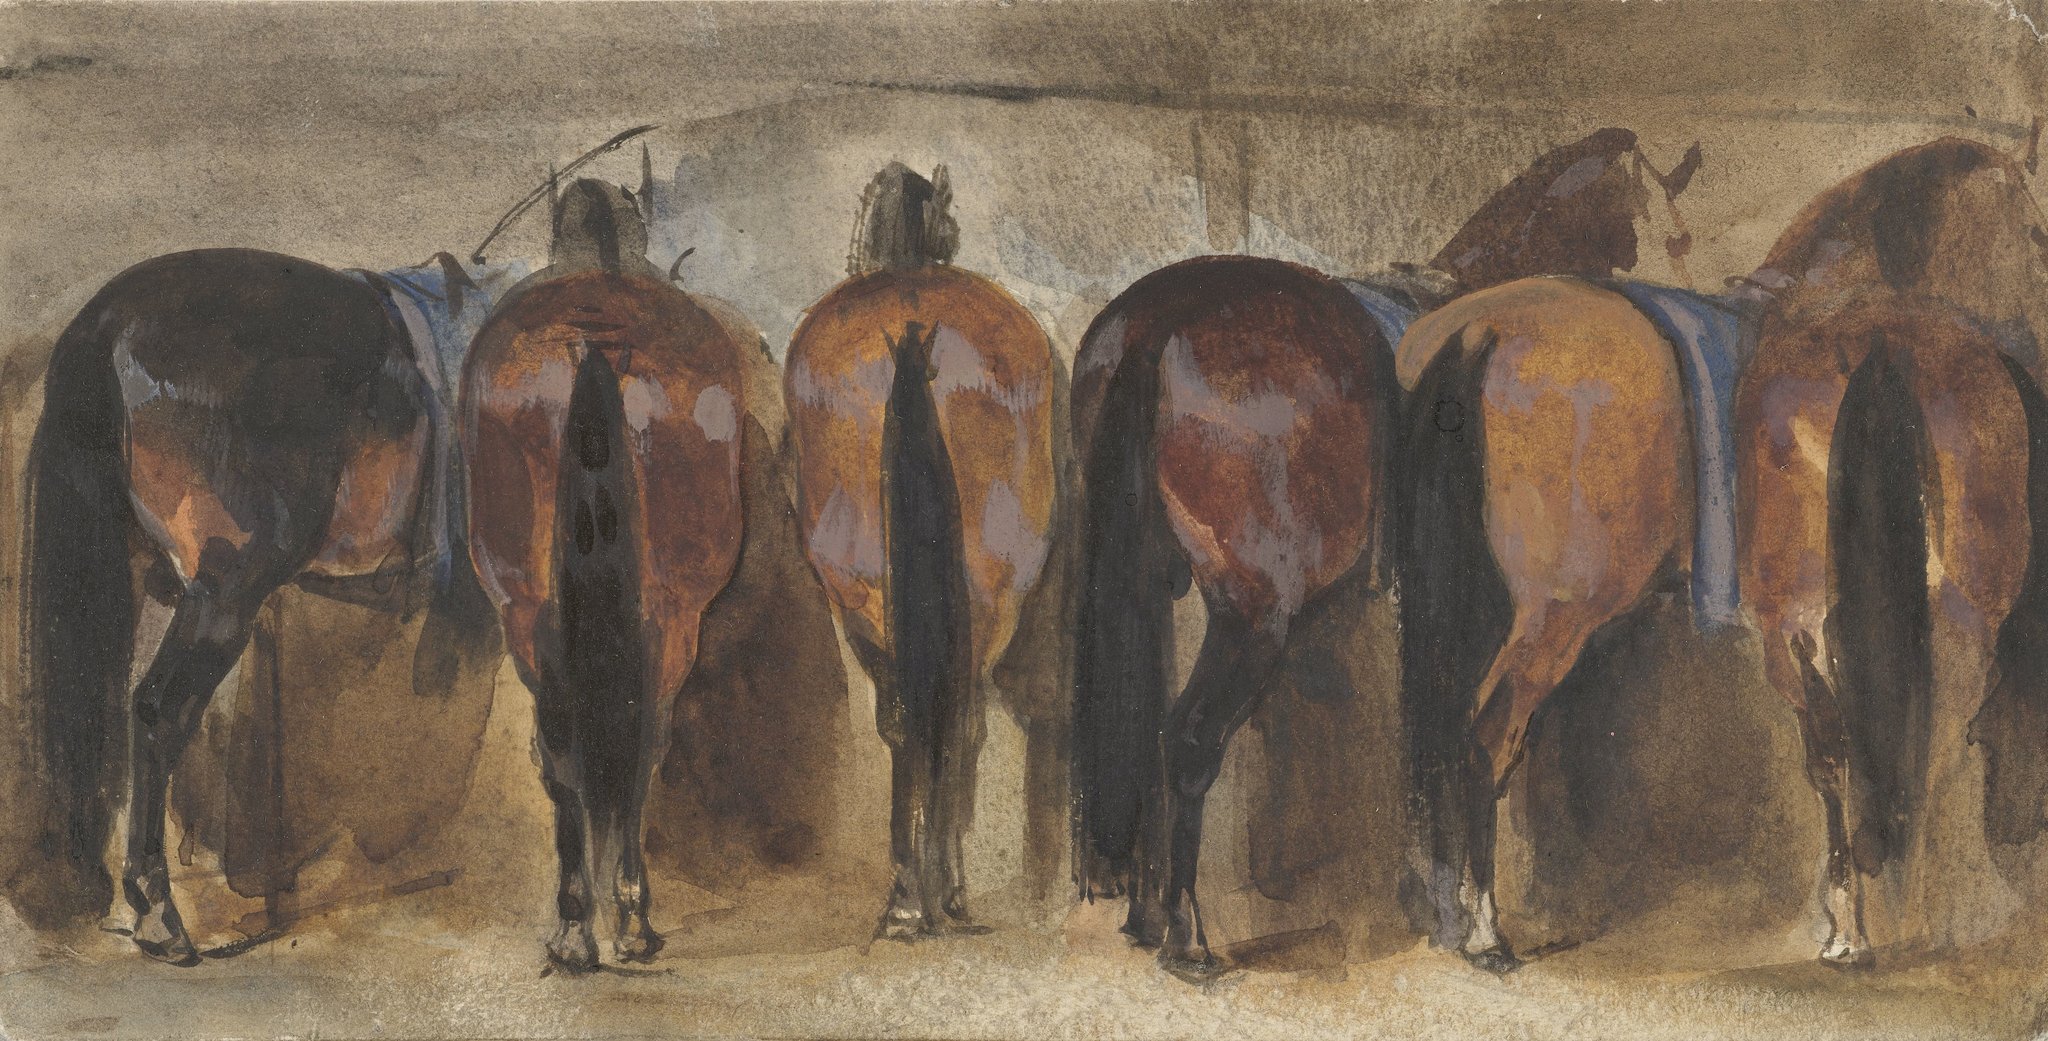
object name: drawing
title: Rustende paarden op stal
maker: joseph zephyris gengembre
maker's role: draughtsman, print maker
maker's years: 1818-1870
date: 1839-1870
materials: paint, paper, watercolor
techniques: brush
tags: barn